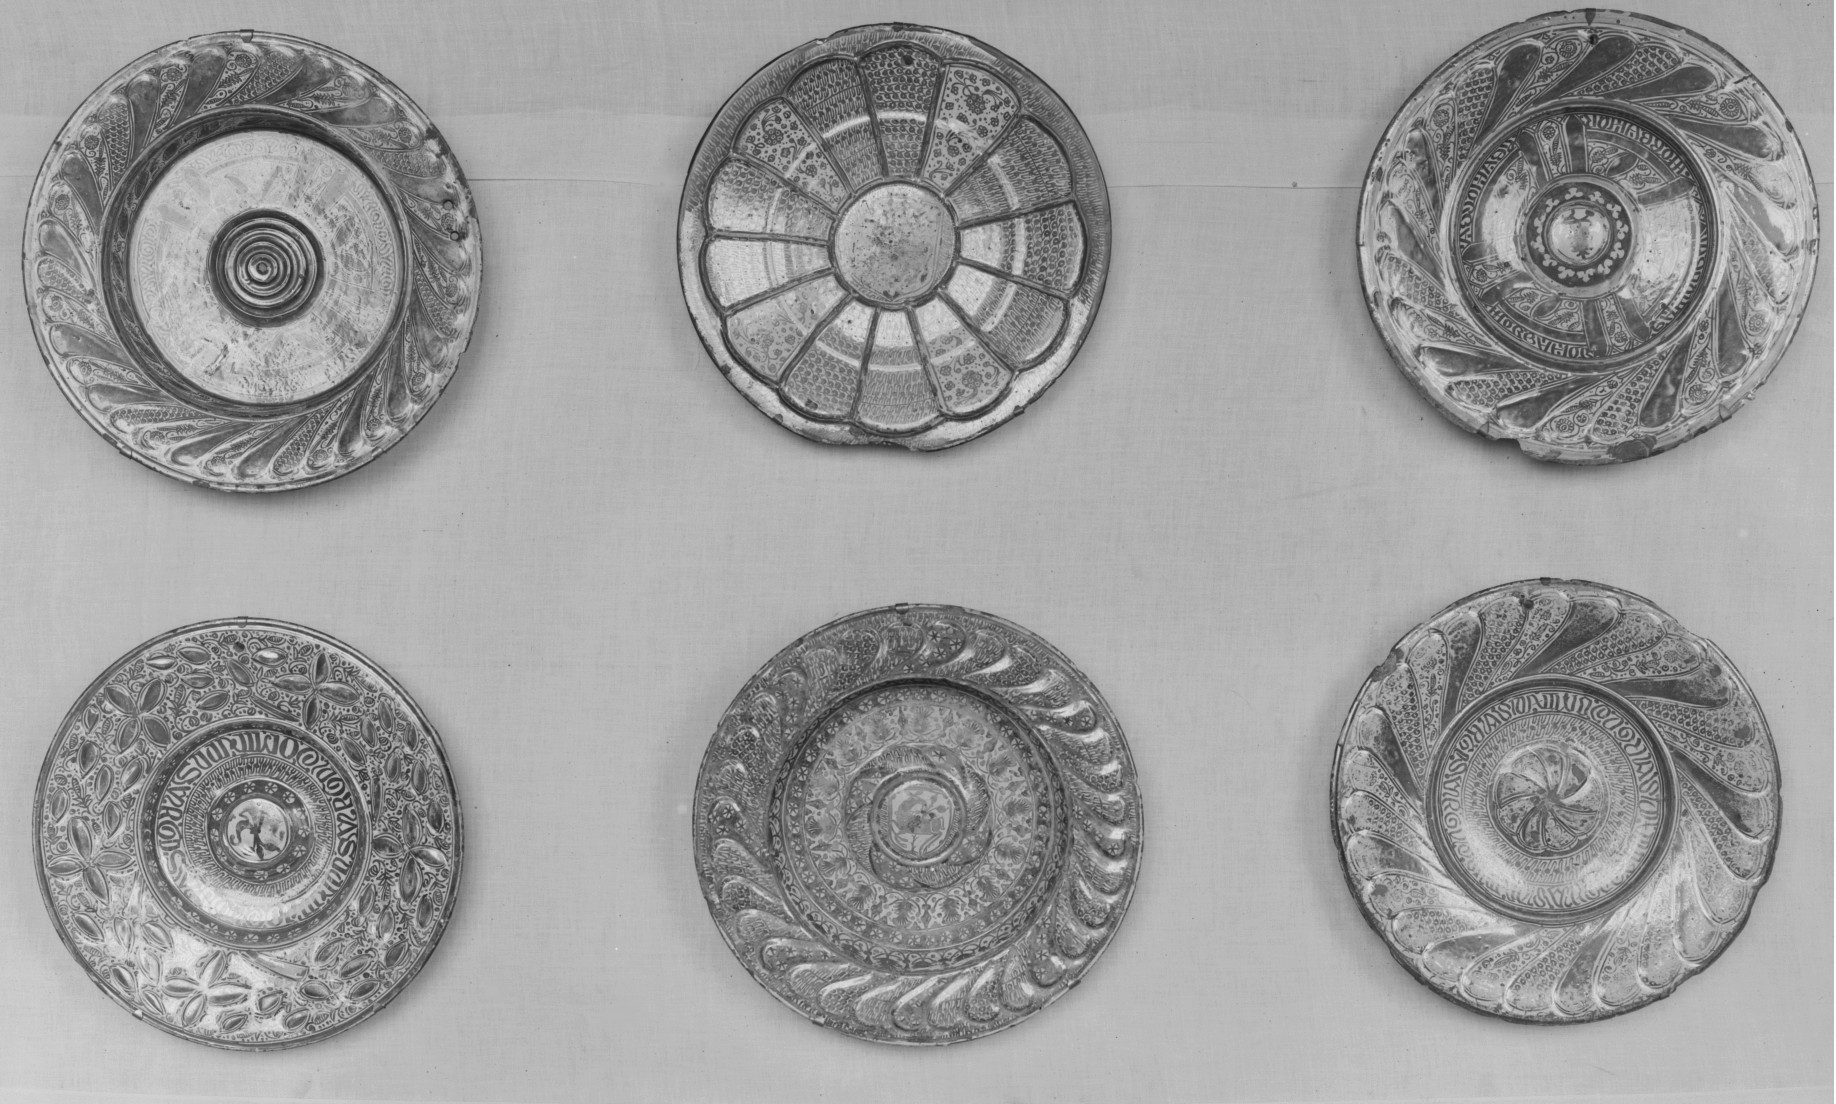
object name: plate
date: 1501-1600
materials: earthenware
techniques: luster painting, glazing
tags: flowers